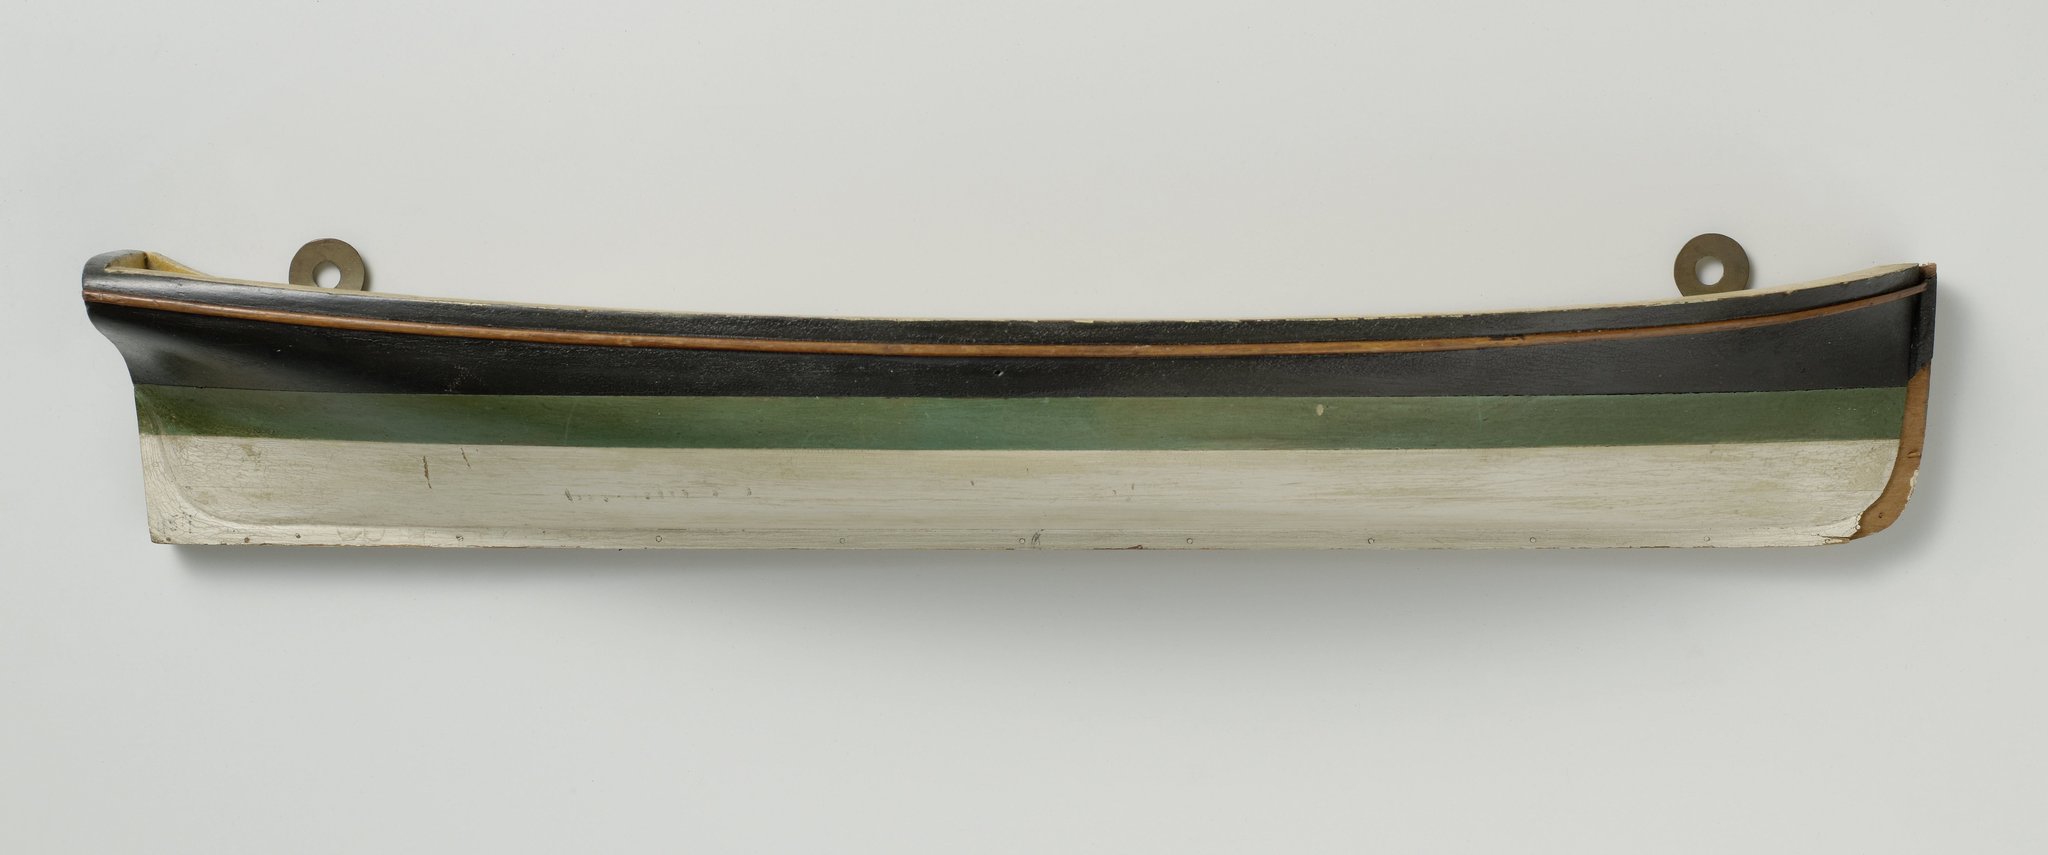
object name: ship model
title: Half Model of a Launch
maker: Anonymous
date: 1850-1852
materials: wood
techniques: polychromy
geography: united states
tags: noord- en centraal amerika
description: Gepolychromeerd blokmodel (stuurboord) van een sloep. Platte spiegel. De zeeg loopt op naar beide uiteinden, één barkhout. Gepiekt rondspant.